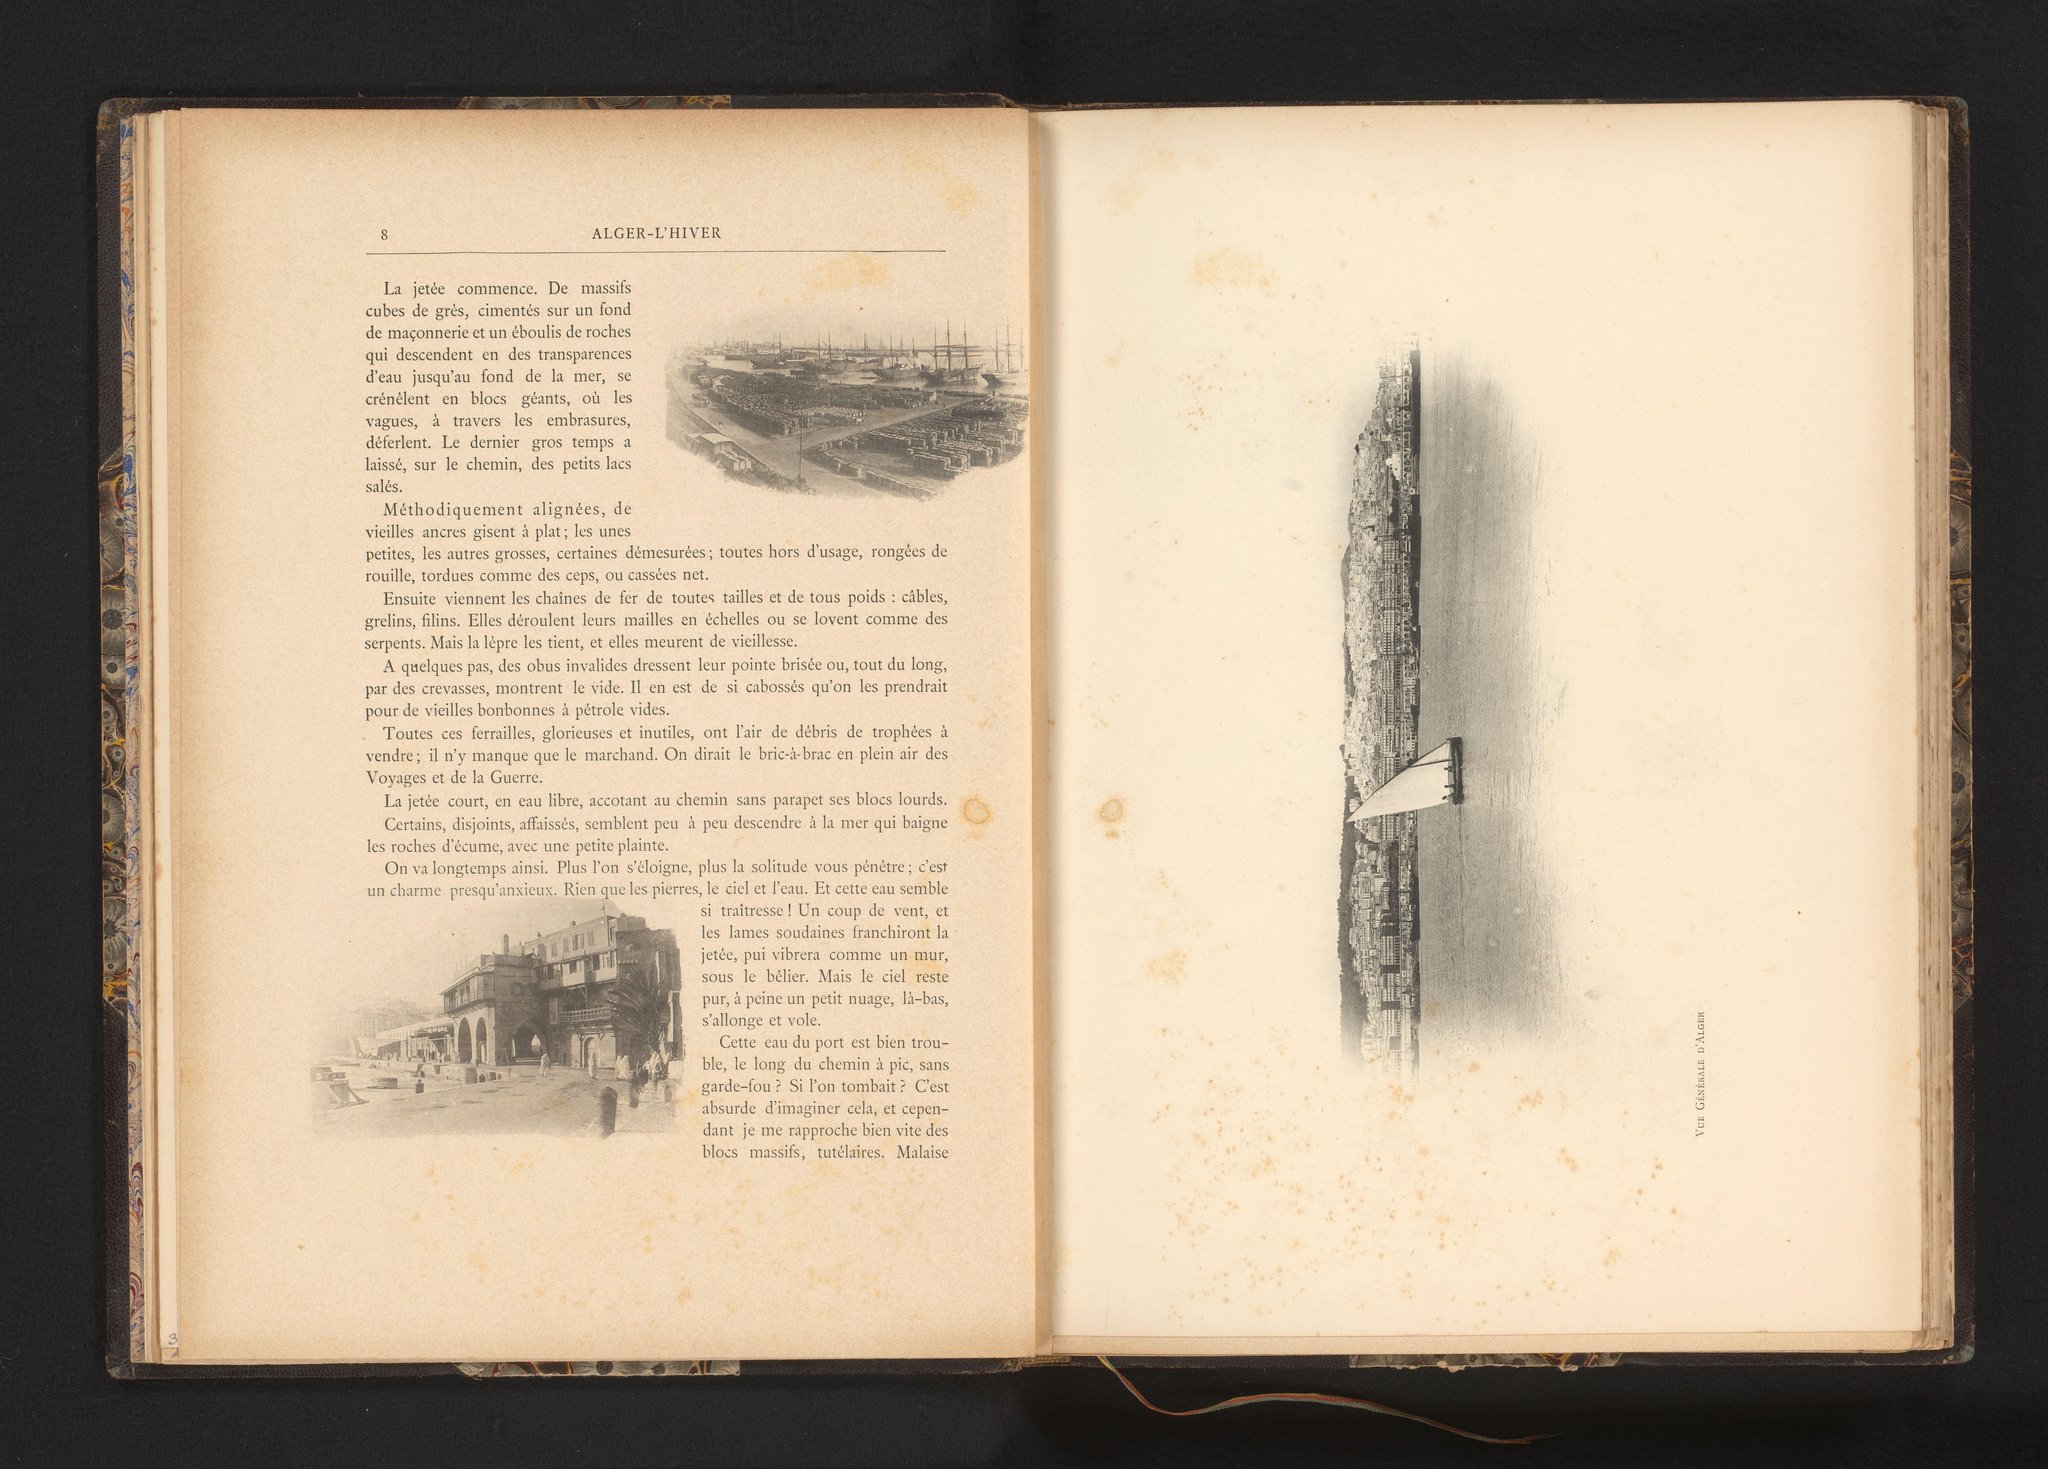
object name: page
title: Gezicht op een straat langs de haven van Algiers, Algerije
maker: jules gervais-courtellemont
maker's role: fotograaf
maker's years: 1863-1931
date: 1888-1893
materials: paper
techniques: photograph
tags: harbour, street